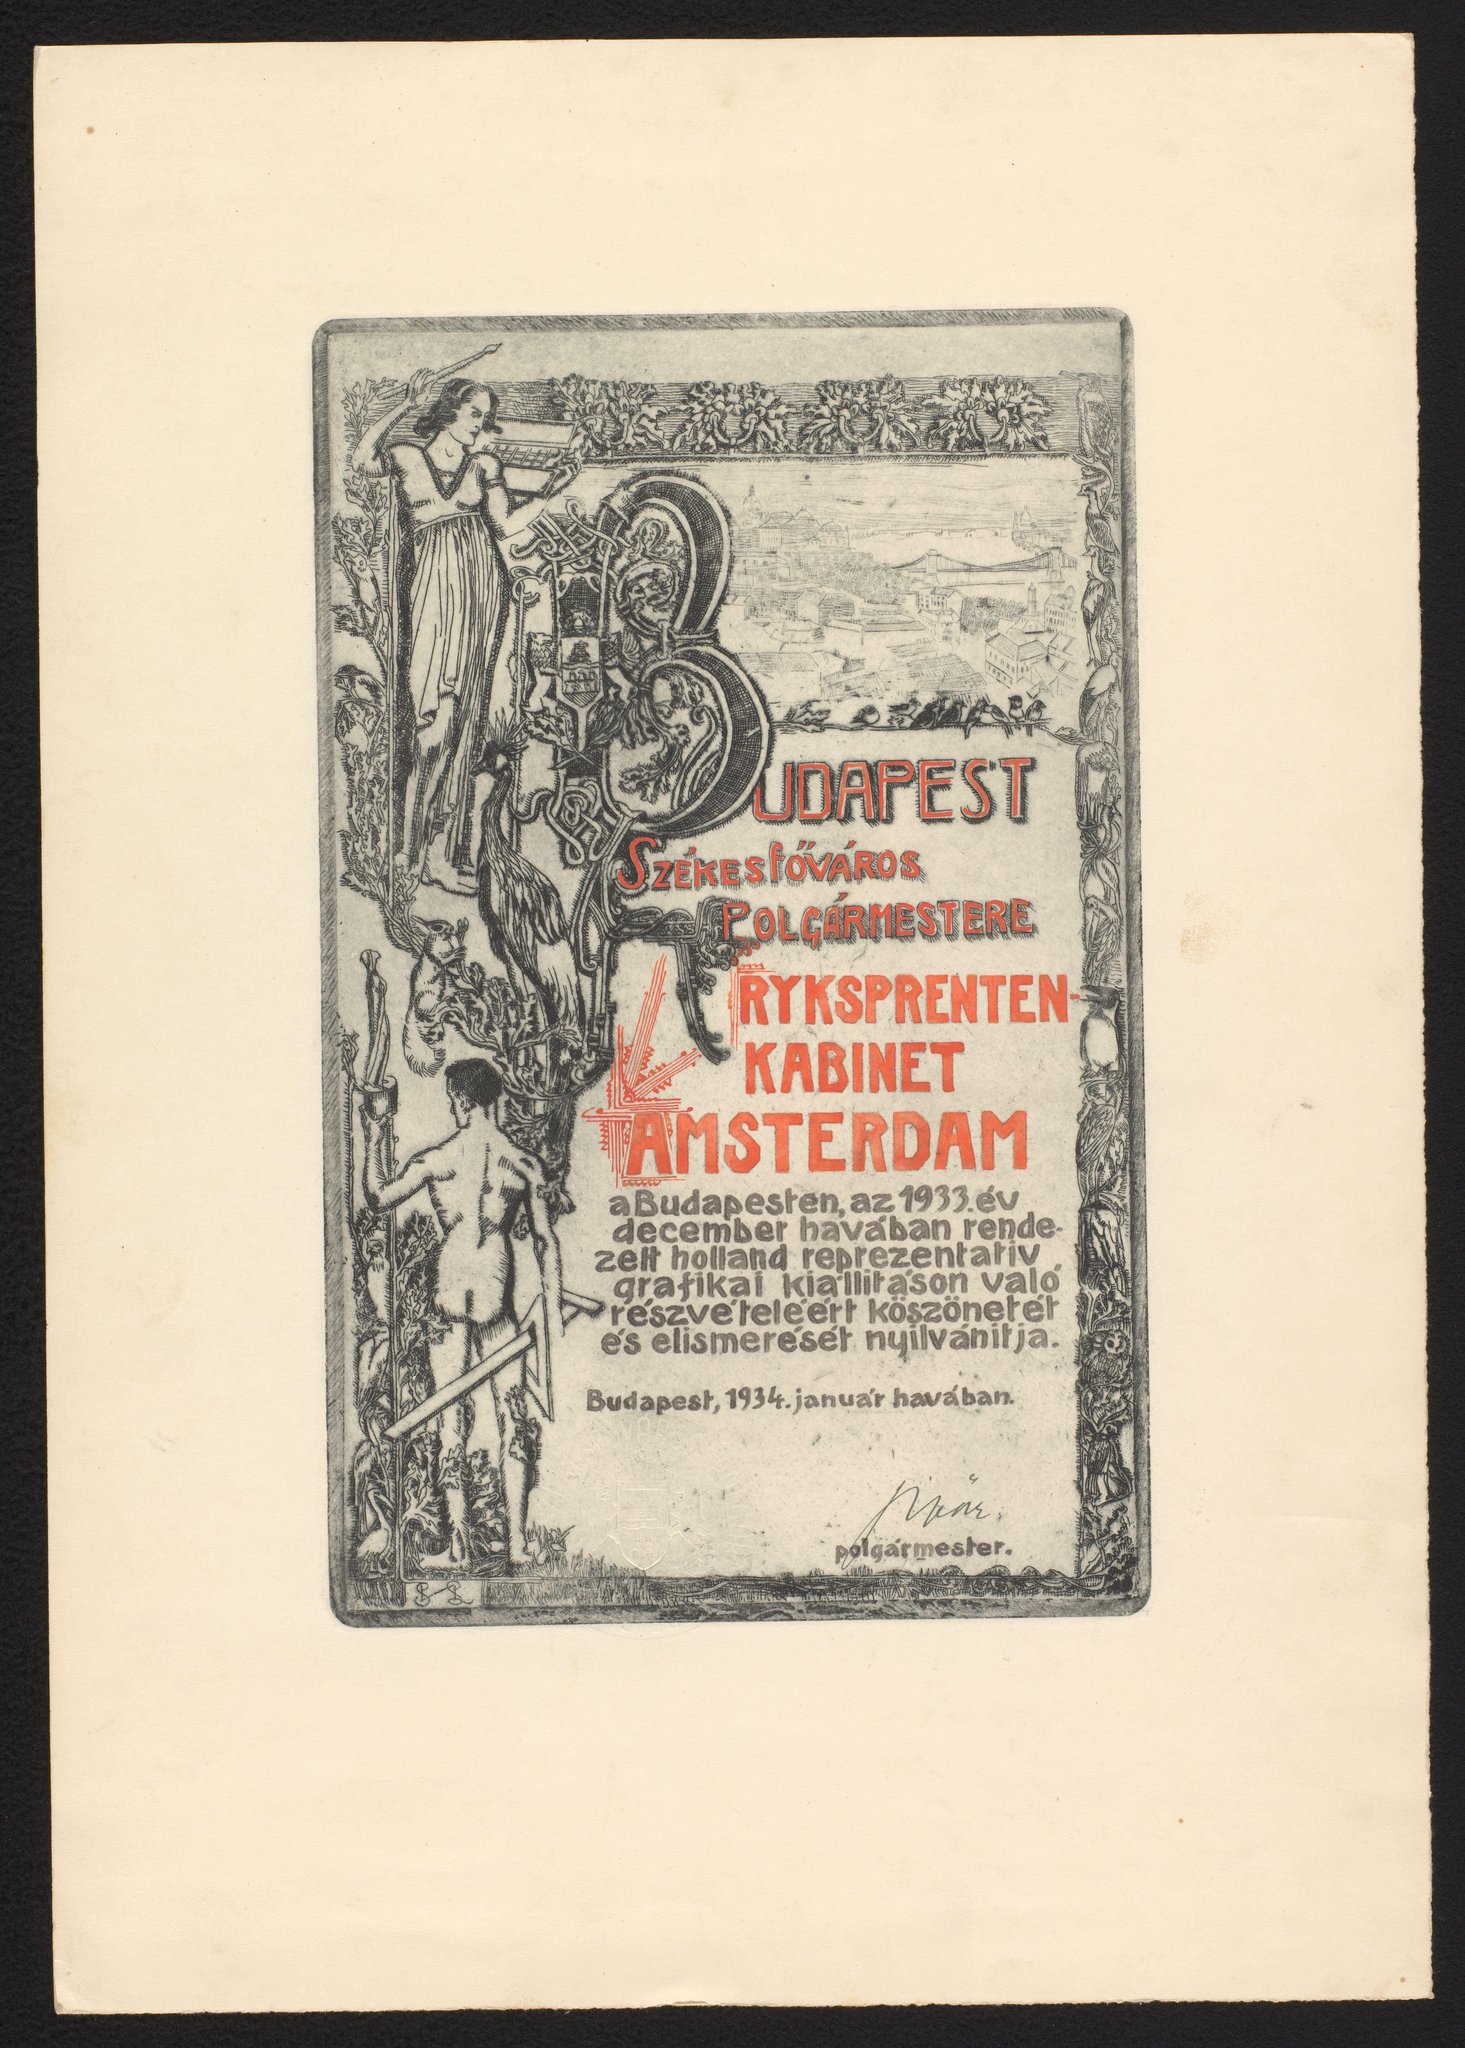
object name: print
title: Dankbetuiging van de burgemeester van Boedapest voor deelname aan een tentoonstelling van Nederlandse grafische kunst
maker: Anonymous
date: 1901-1934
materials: paper, watercolor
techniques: brush, etching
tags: shore-birds and wading-birds: crane, palette, brushes ~ implements of painter, square (drawing-instrument), rodents: squirrel, man (showing himself) undressed, quasi-nude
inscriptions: stamp: ‘'Budapest Székesfövarós Polgármestere' rond het wapen van Boedapest’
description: Links een naakte man met tekenhaak, een eekhoorn en een kraanvogel onder een vrouw met penseel en verfdoos. Naast de vrouw een groot initiaal B aan het begin van de tekst: 'Budapest székesföváros polgármestere (...) és elismerését nyilvánitja' ('uit dankbaarheid en erkenning voor deelname aan de representatieve tentoonstelling van Nederlandse grafische kunst die in december 1933 in Boedapest gehouden werd'). Alleen de eerste drie woorden van deze tekst zijn gedrukt, het overige is met de hand toegevoegd in de daarvoor bestemde open ruimte.